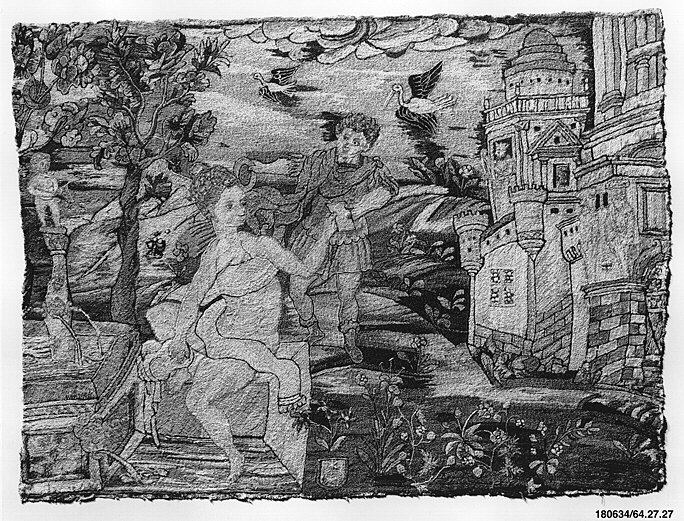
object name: panel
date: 1601-1633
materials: wool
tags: birds,buildings,men,women